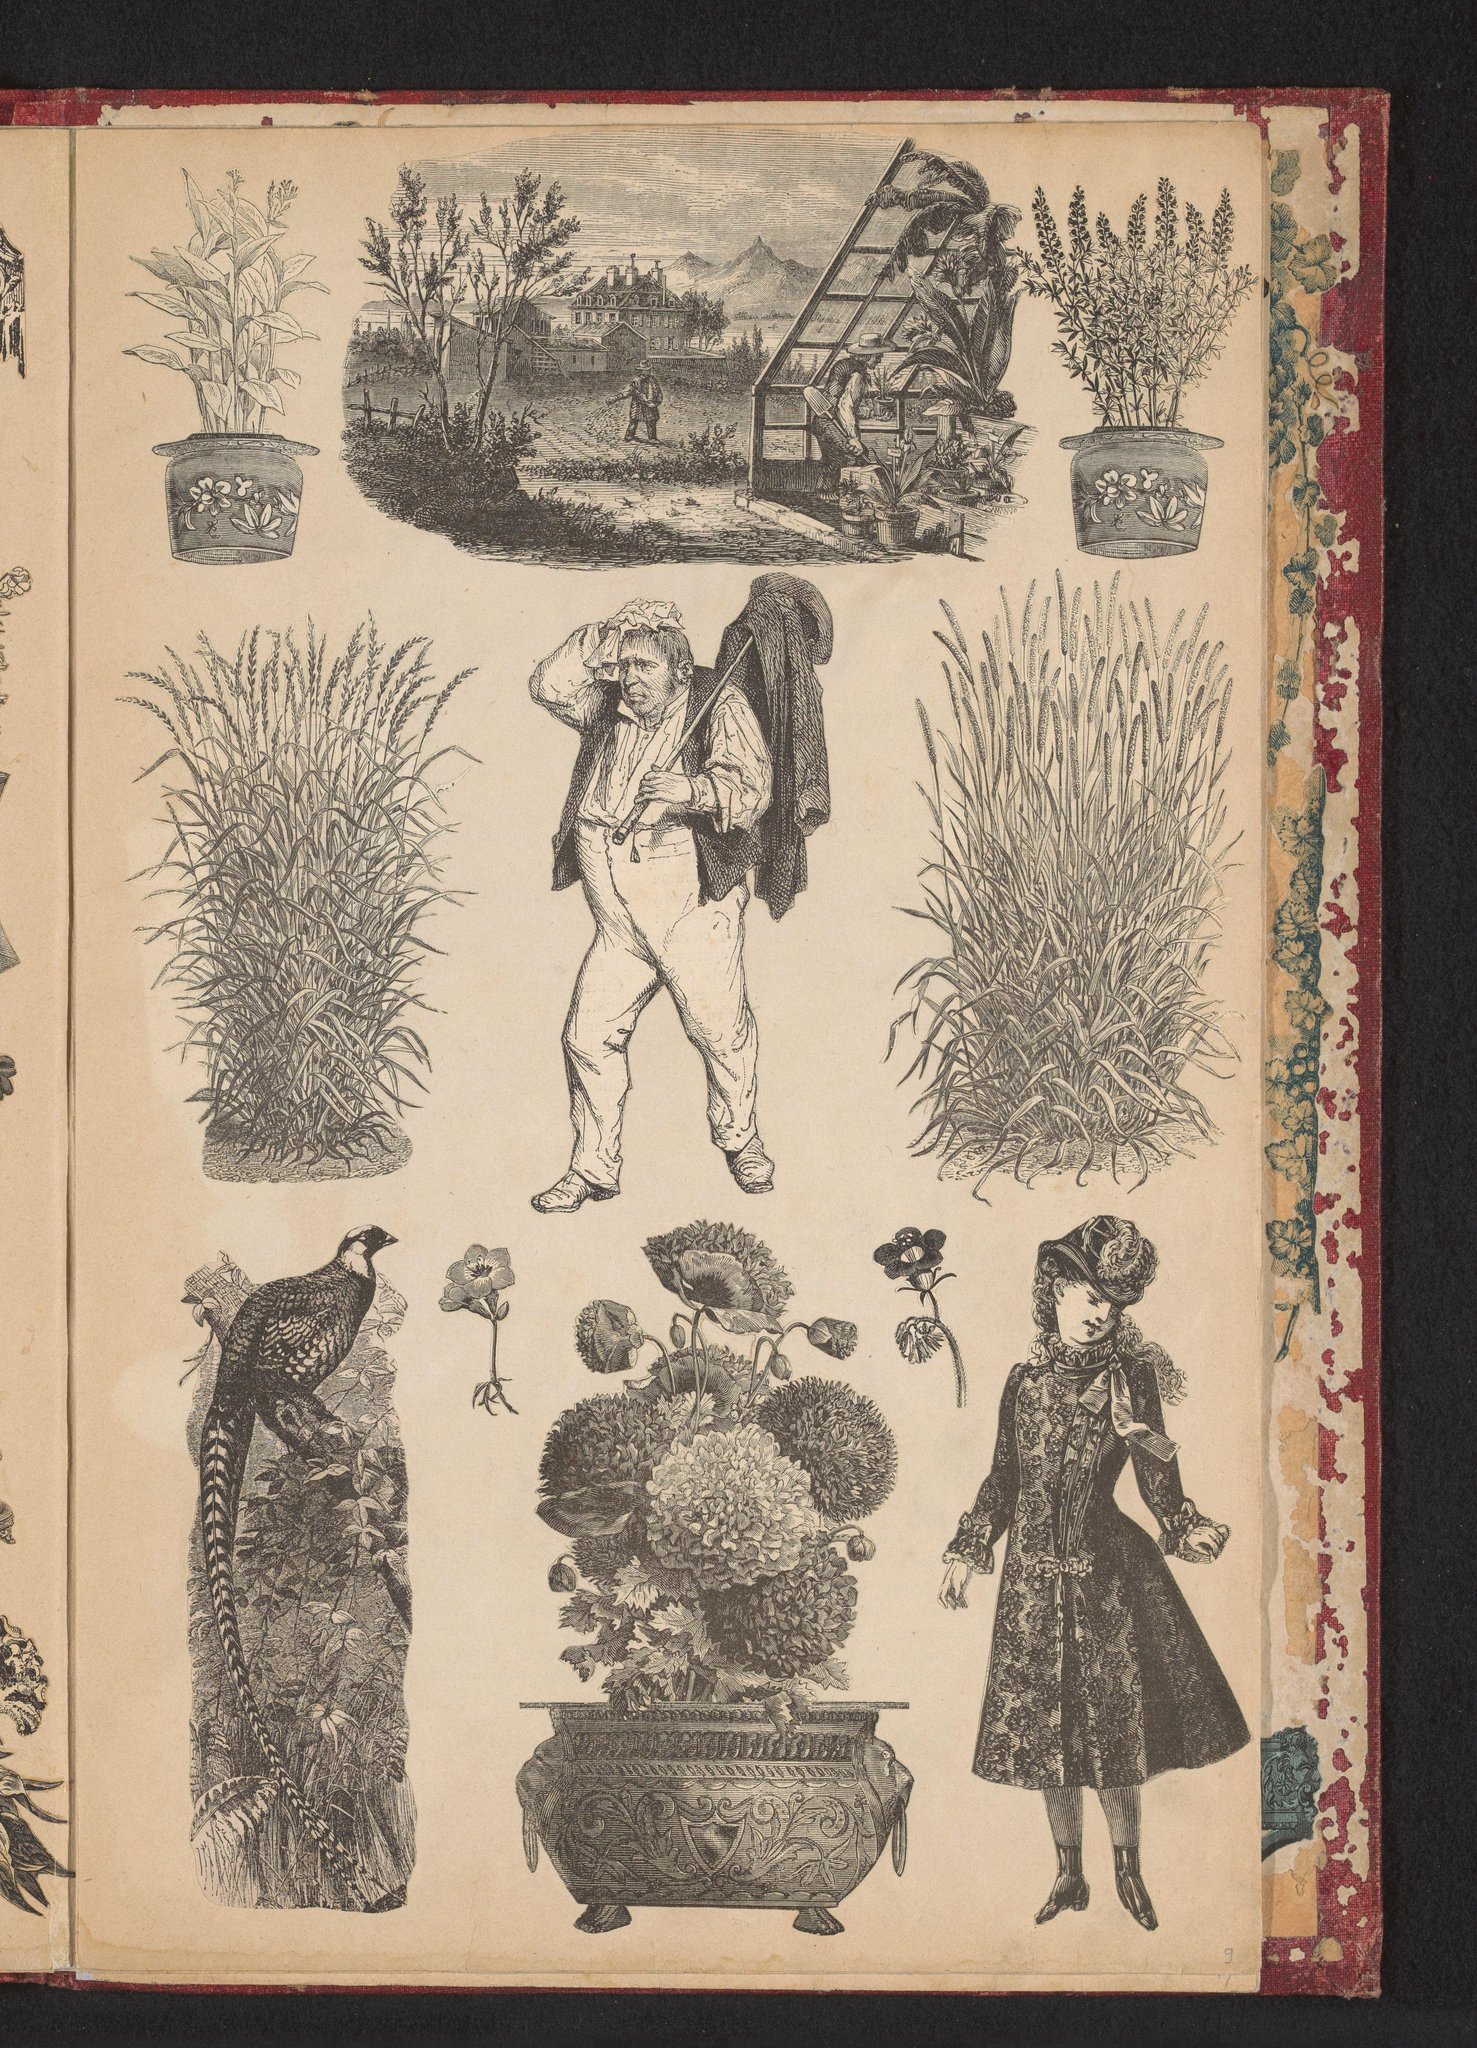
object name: collage visual work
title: Collage van uitgeknipte prenten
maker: Anonymous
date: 1870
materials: paper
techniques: engraving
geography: paris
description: Collage van uitgeknipte prenten. Onderdeel van een album met 18 bladen, aan beide zijden beplakt met uitgeknipte prenten, vermoedelijk afkomstig uit 19e-eeuwse tijdschiften.